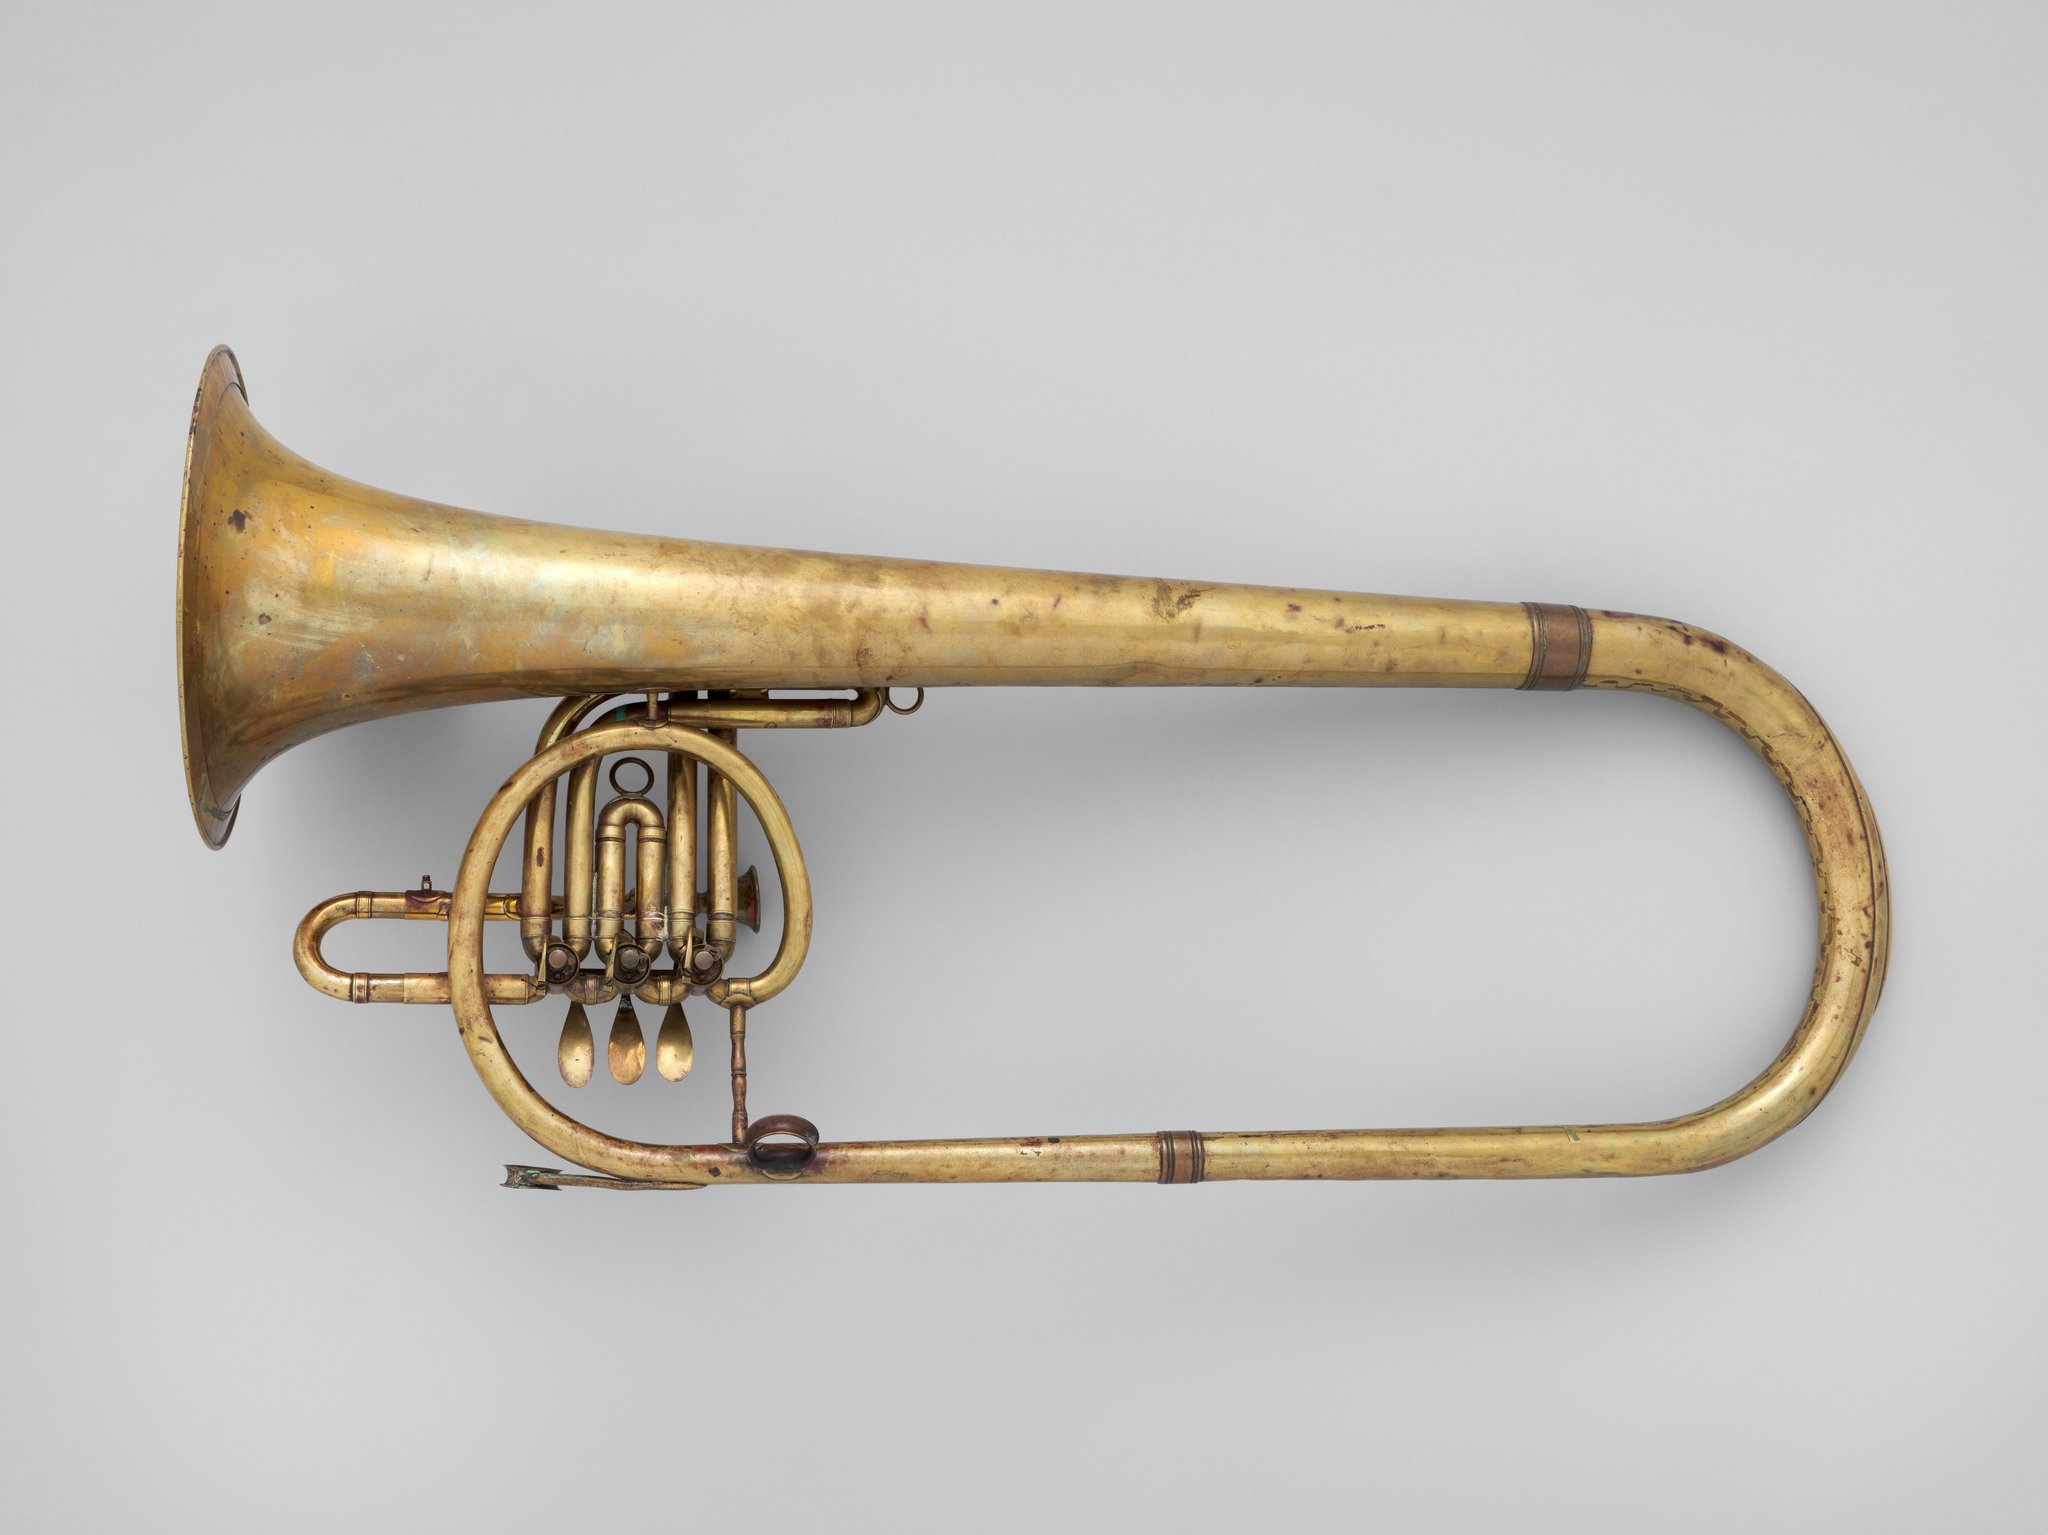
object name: baritone horn in b flat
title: Baritone shoulder horn in B-flat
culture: american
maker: henry g. lehnert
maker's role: maker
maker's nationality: german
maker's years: 1838-1916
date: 1875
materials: brass, nickel, silver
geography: united states